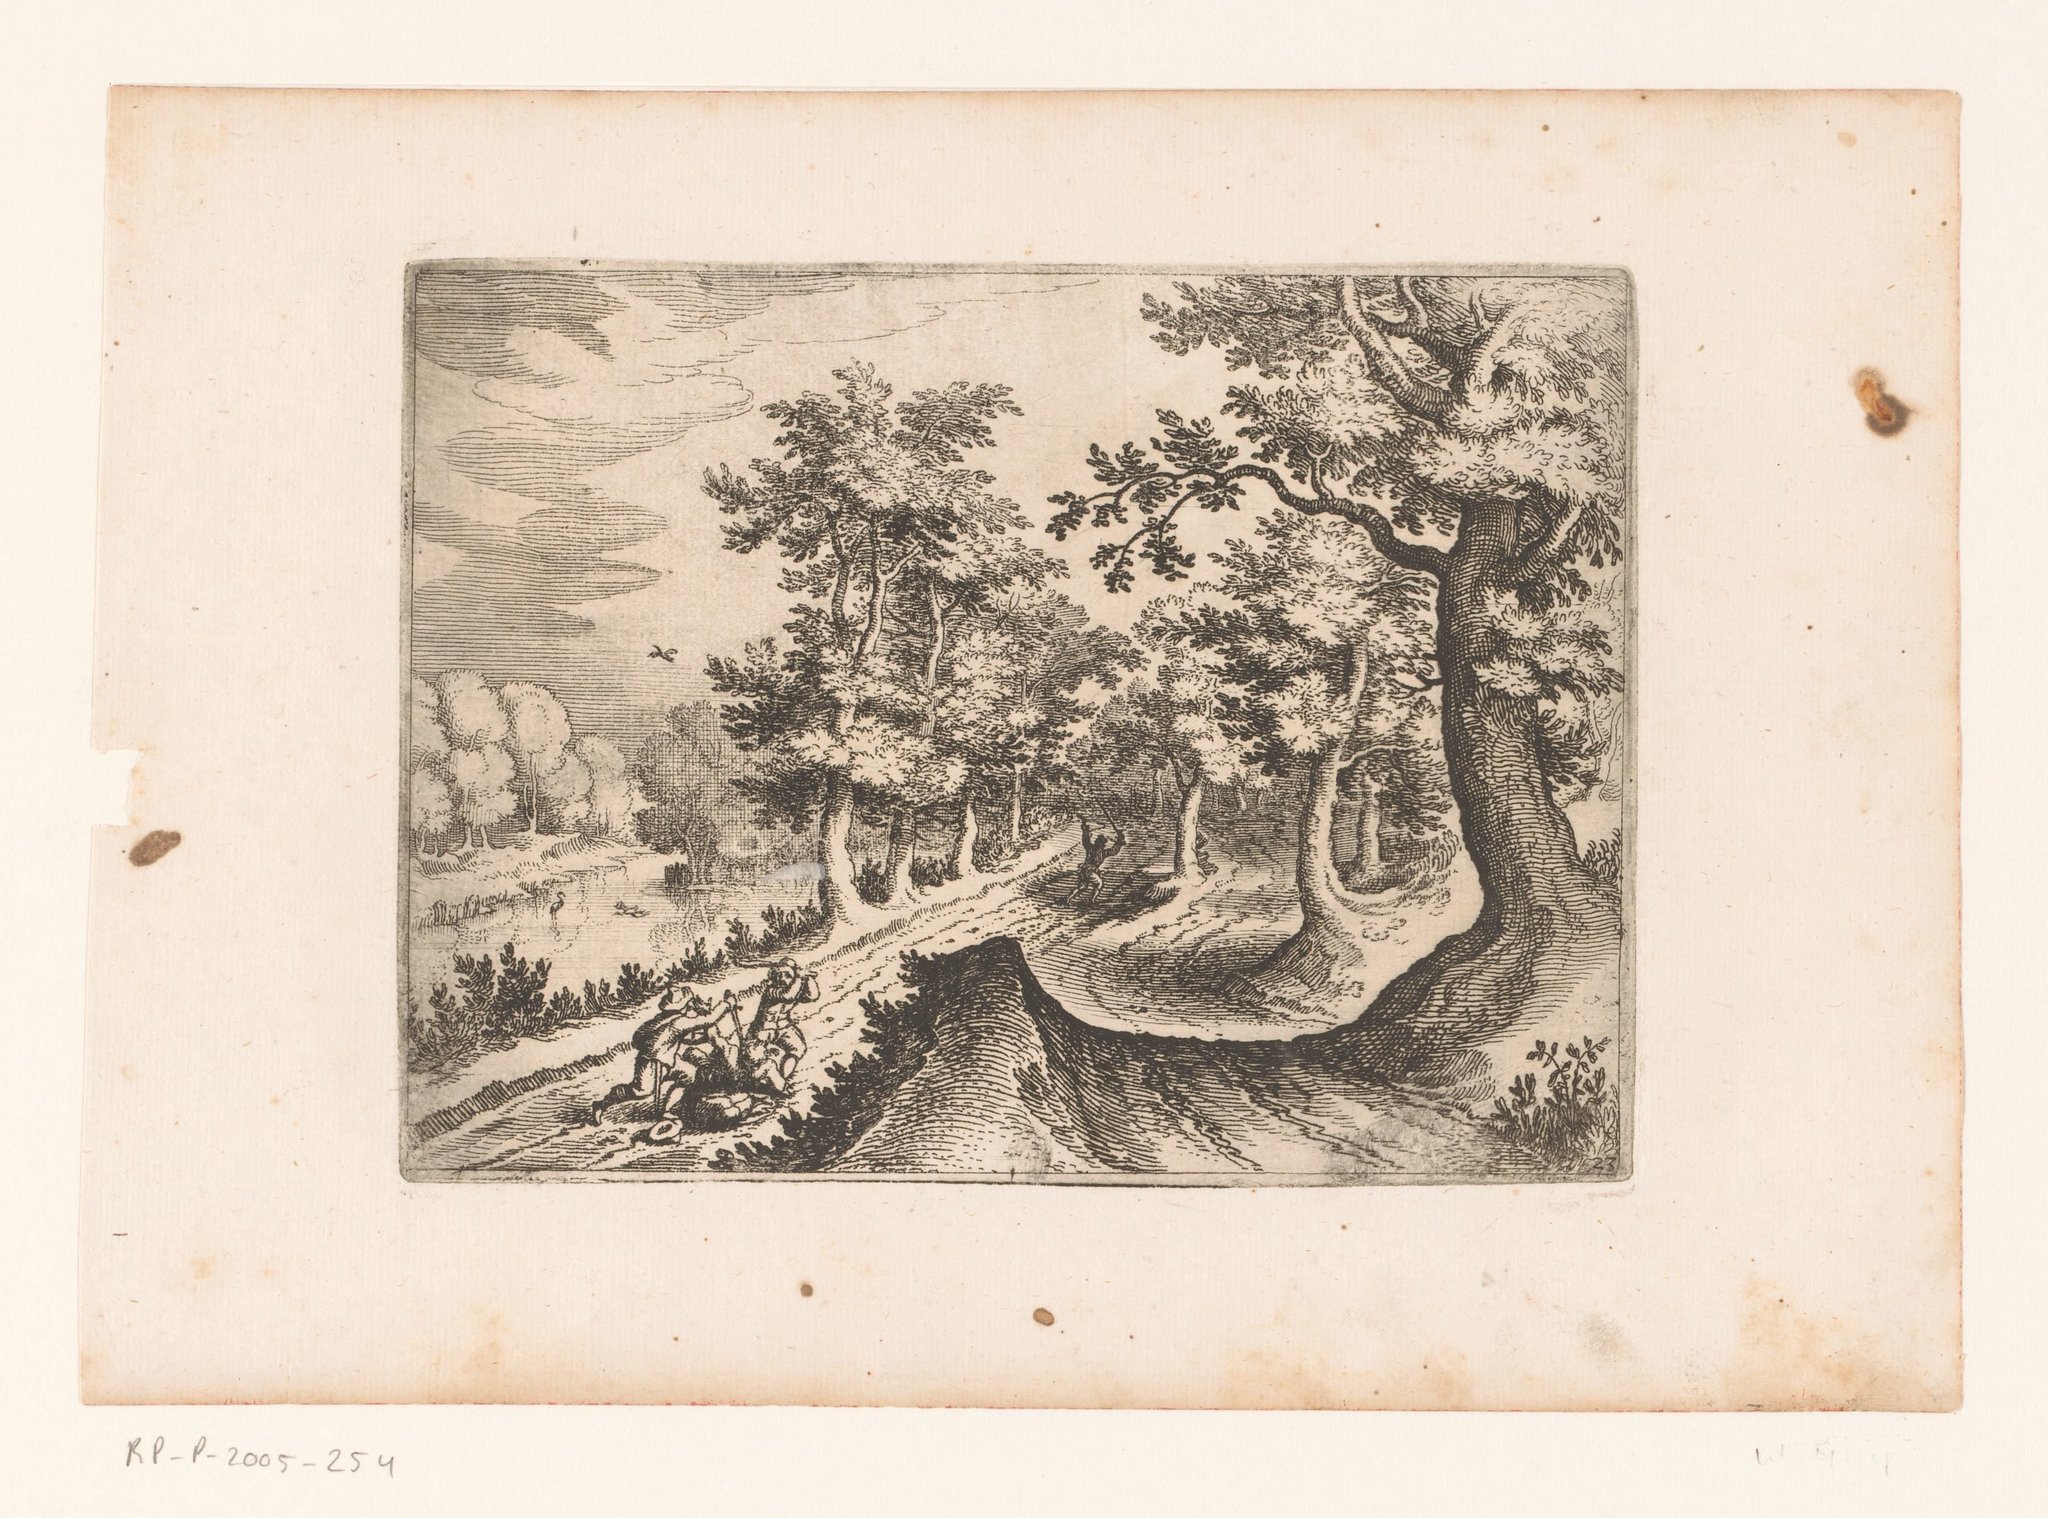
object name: print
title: Overval op een landweg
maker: matthäus merian (i)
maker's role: print maker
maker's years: 1593-1650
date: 1620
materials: paper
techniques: etching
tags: river, traveller(s) attacked by robber(s), fringe, edge of the wood, road, path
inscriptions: collector's mark: Lugt 2228, collector's mark: Lugt 2760